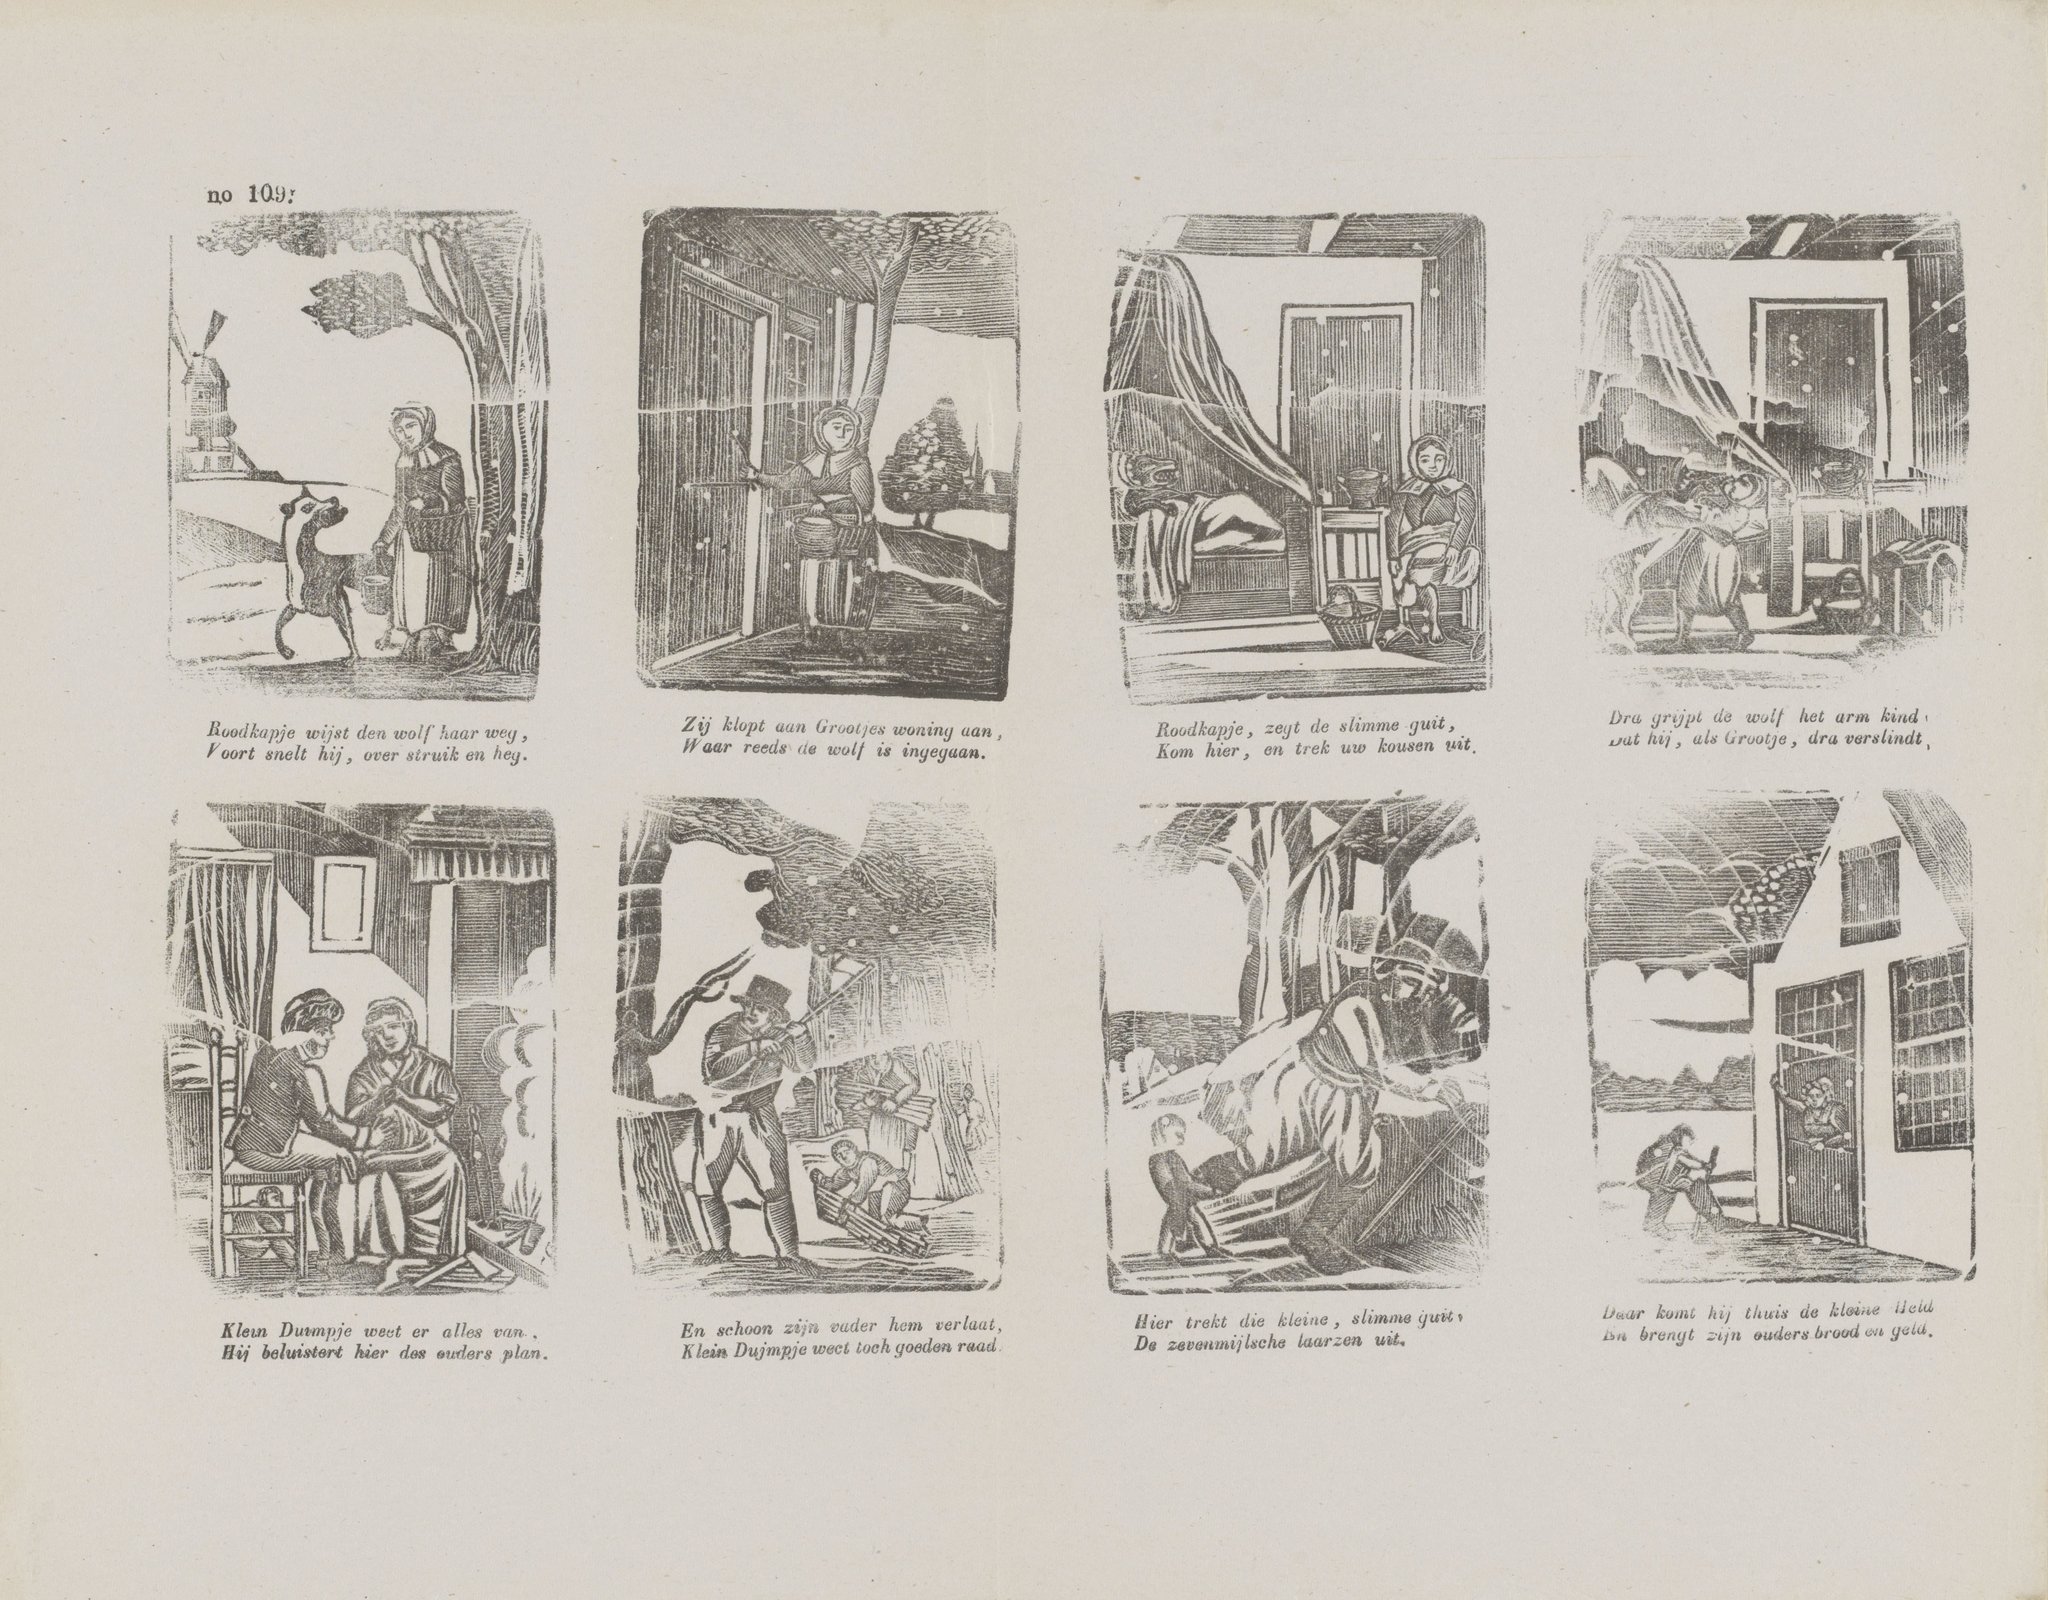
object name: print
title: Roodkapje en Klein Duimpje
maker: Anonymous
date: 1848-1881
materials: paper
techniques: letterpress printing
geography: netherlands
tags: tales and fairy tales: little red riding-hood, tales and fairy tales: little thumbling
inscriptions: collector's mark: Lugt 2760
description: Blad met 8 voorstellingen uit de sprookjes van Roodkapje en Klein Duimpje. Onder elke voorstelling een tweeregelig vers. Genummerd linksboven: no 109.